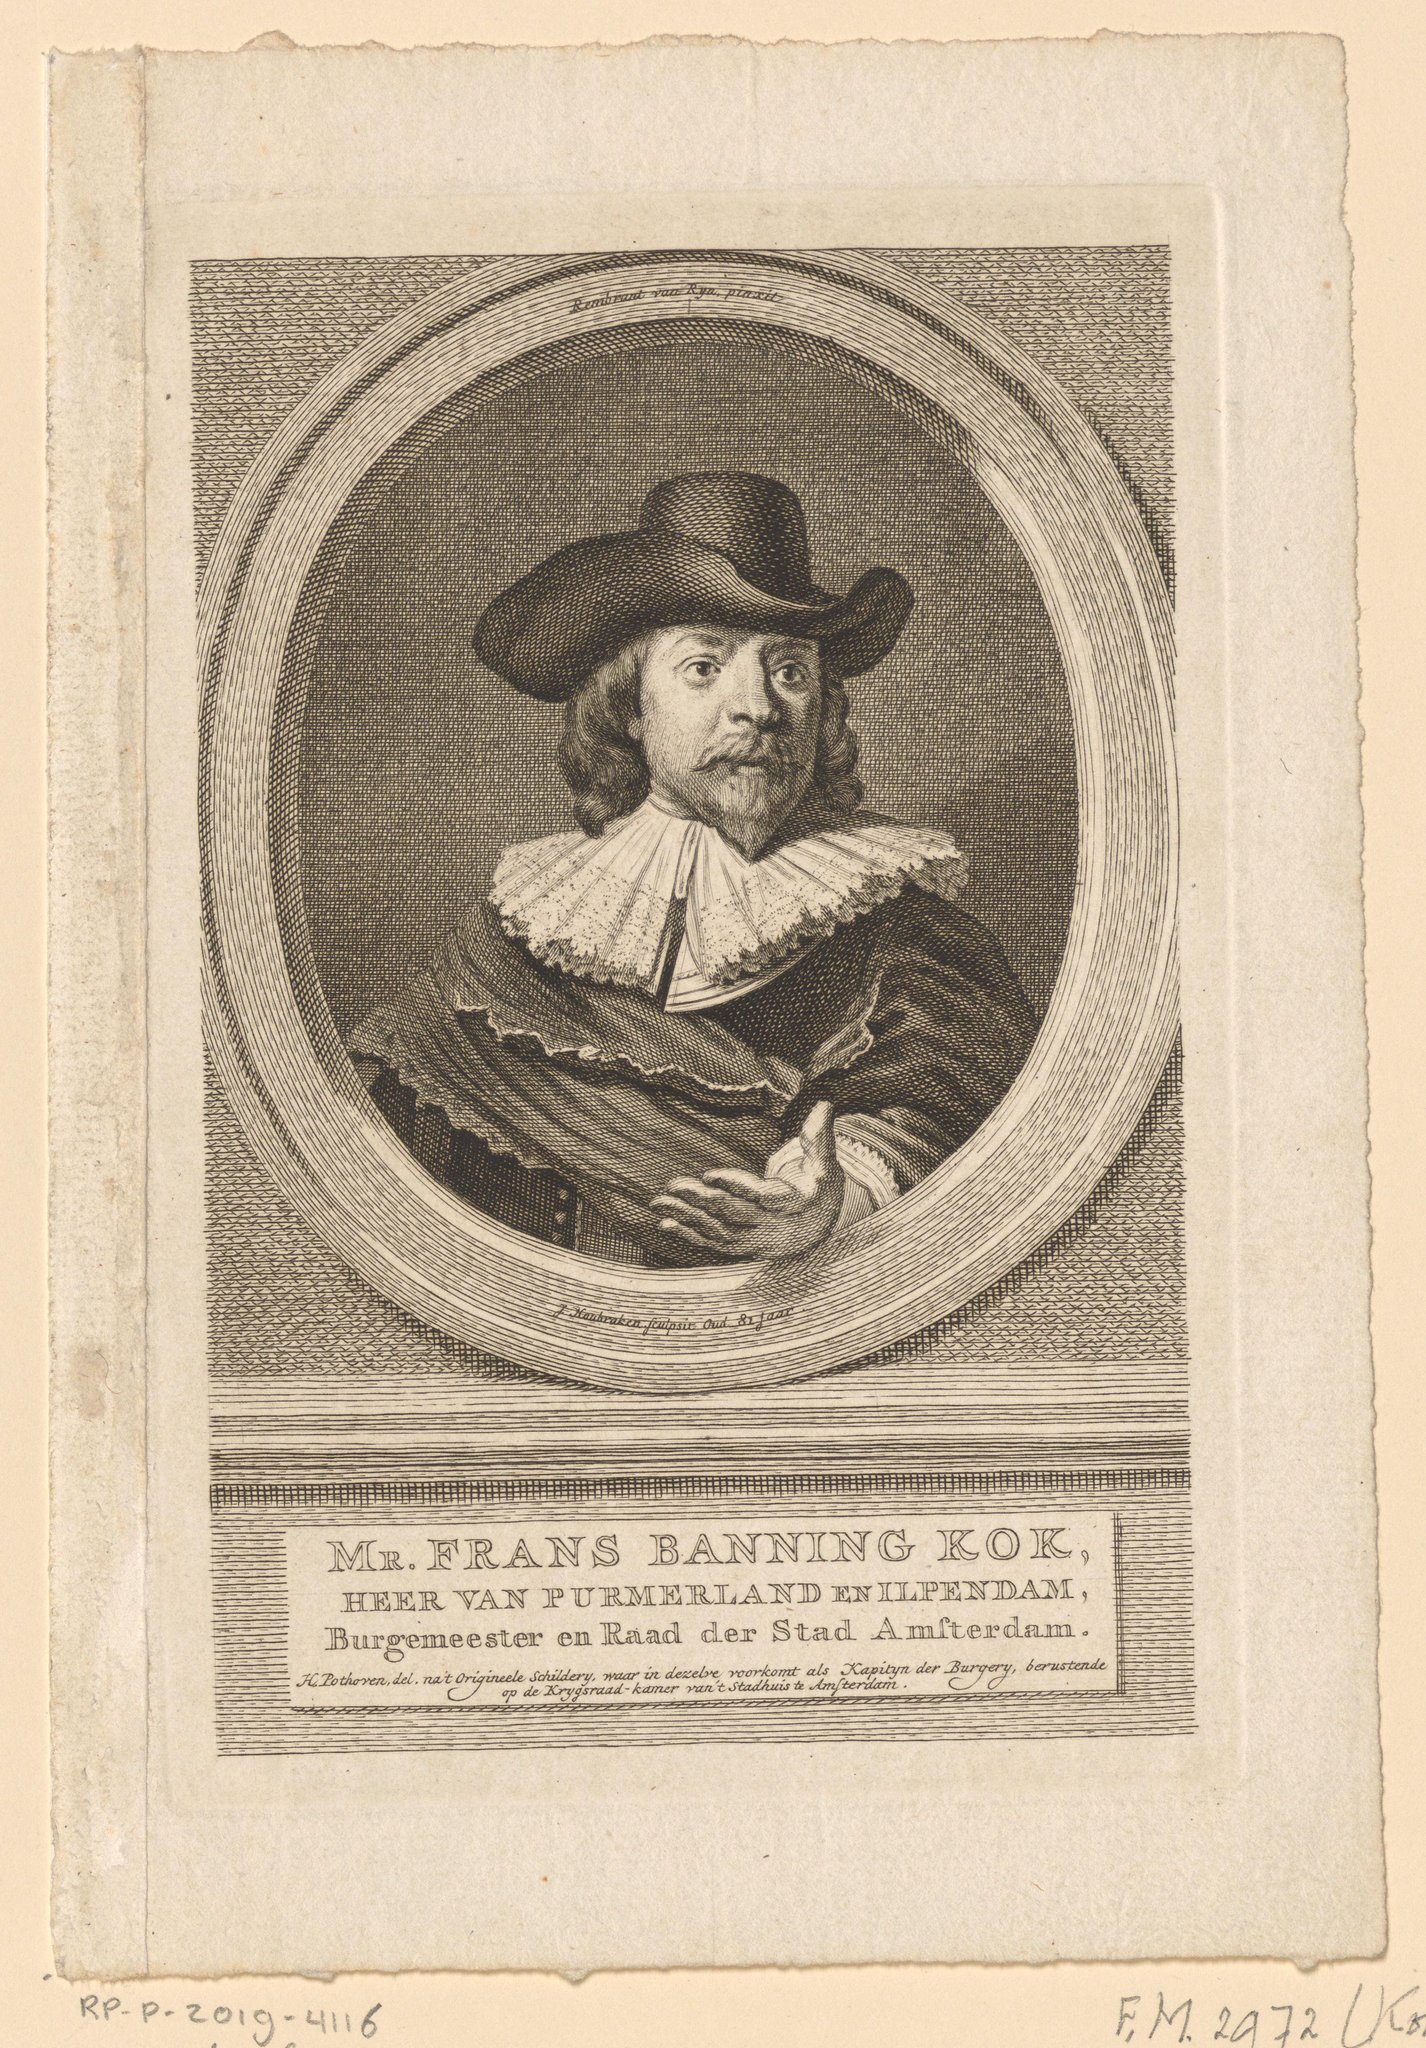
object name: book illustration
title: Portret van Frans Banninck Cocq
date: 1796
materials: paper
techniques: engraving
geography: amsterdam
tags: mayor, frans banninck cocq, historical persons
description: Prent bedoeld als aanvulling op Jan Wagenaars 'Vaderlandsche historie’ en was zo vanaf 1796 verkrijgbaar bij Johannes Allart te Amsterdam. Voor de advertentie waarin Allart de 60 portretten en 7 platen, allen gegraveerd door Houbraken, ter aanvulling op Wagenaars ‘Vaderlandsche historie’ aanbiedt, zie RP-P-OB-77.766. Van Wagenaars 'Vaderlandsche historie' zijn meerdere edities: Wagenaar, Jan. Vaderlandsche historie, vervattende de geschiedenissen der Vereenigde Nederlanden (…). 21 delen. Amsterdam: Isaak Tirion, 1749-1759. Wagenaar, Jan. Vaderlandsche historie, vervattende de geschiedenissen der nu Vereenigde Nederlanden (…). 21 delen. Amsterdam: weduwe Isaak Tirion, 1770. Wagenaar, Jan. Vaderlandsche historie, vervattende de geschiedenissen der nu Vereenigde Nederlanden (…). 21 delen. Amsterdam, Leiden, Dordrecht en Harlingen: P. Schouten e.a., 1782. Wagenaar, Jan. Vaderlandsche historie, vervattende de geschiedenissen der nu Vereenigde Nederlanden (…). 21 delen. Amsterdam: Johannes Allart, 1790-1796.